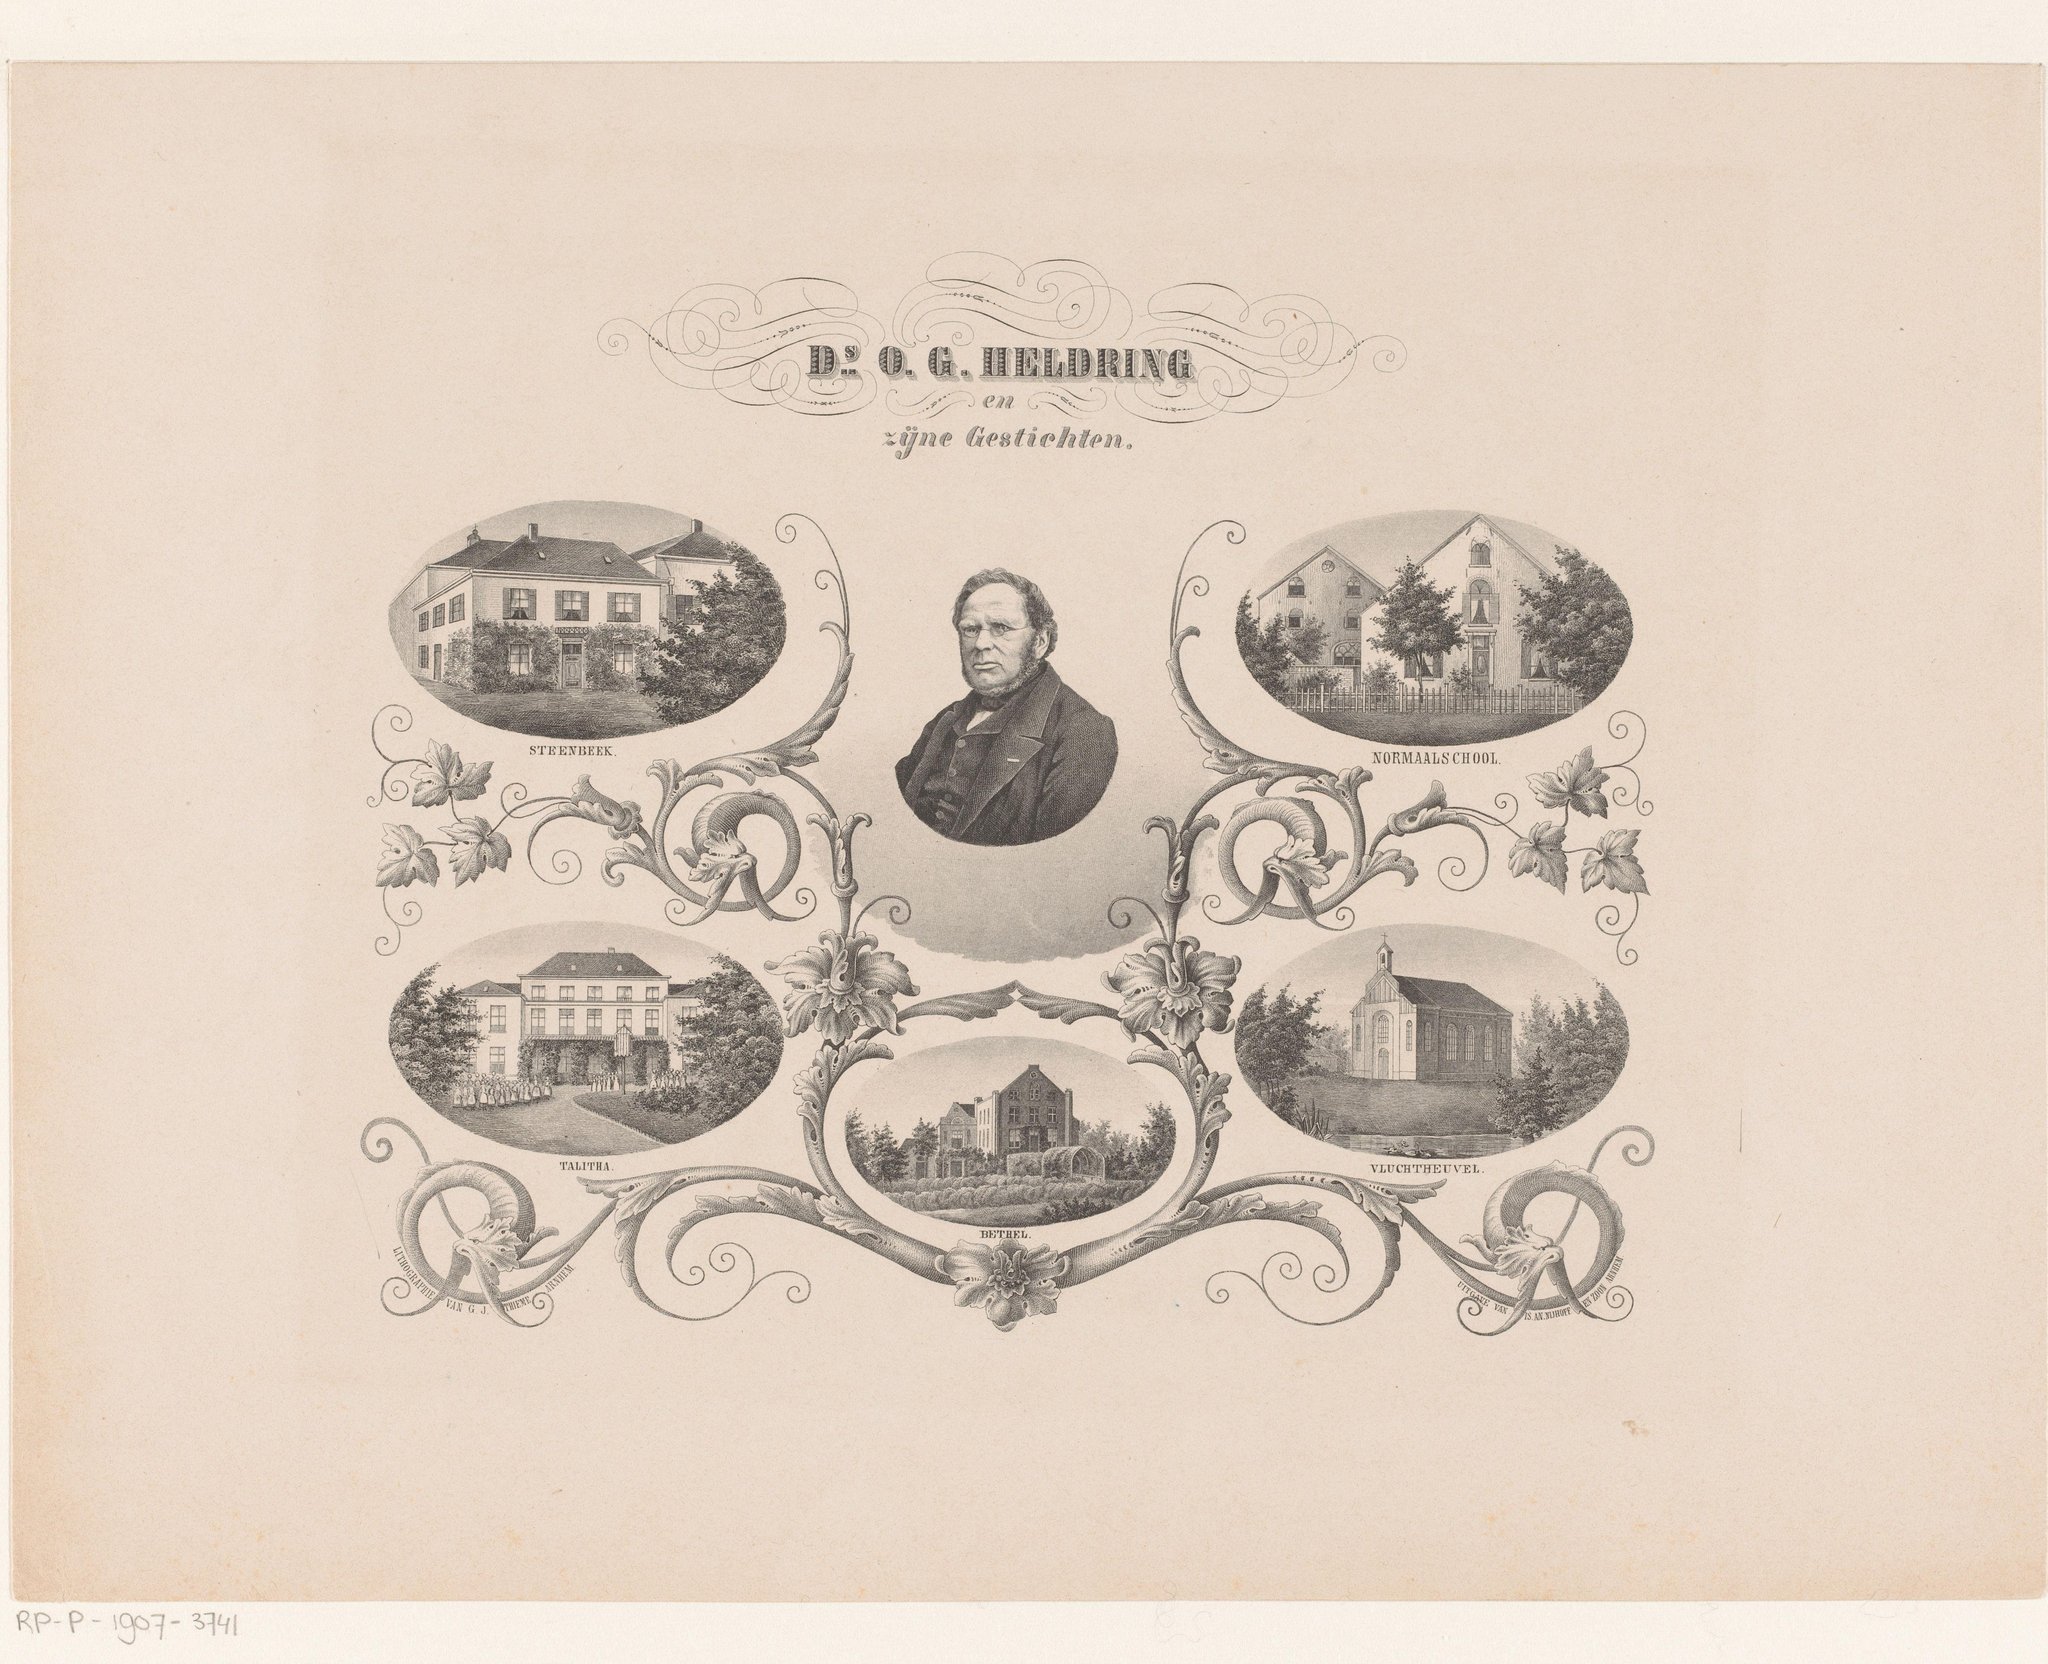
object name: print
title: Portret van Otto Gerhard Heldring en door hem opgerichte gestichten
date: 1848-1863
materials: paper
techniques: lithograph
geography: arnhem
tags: historical persons, lunatic asylum, mental home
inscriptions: collector's mark: Lugt 2228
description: Het portret van Otto Gerhard Heldring omringd door de vijf door hem opgerichte gestichten Steenbeek, Normaalschool, Talitha, Bethel en Vluchtheuvel.